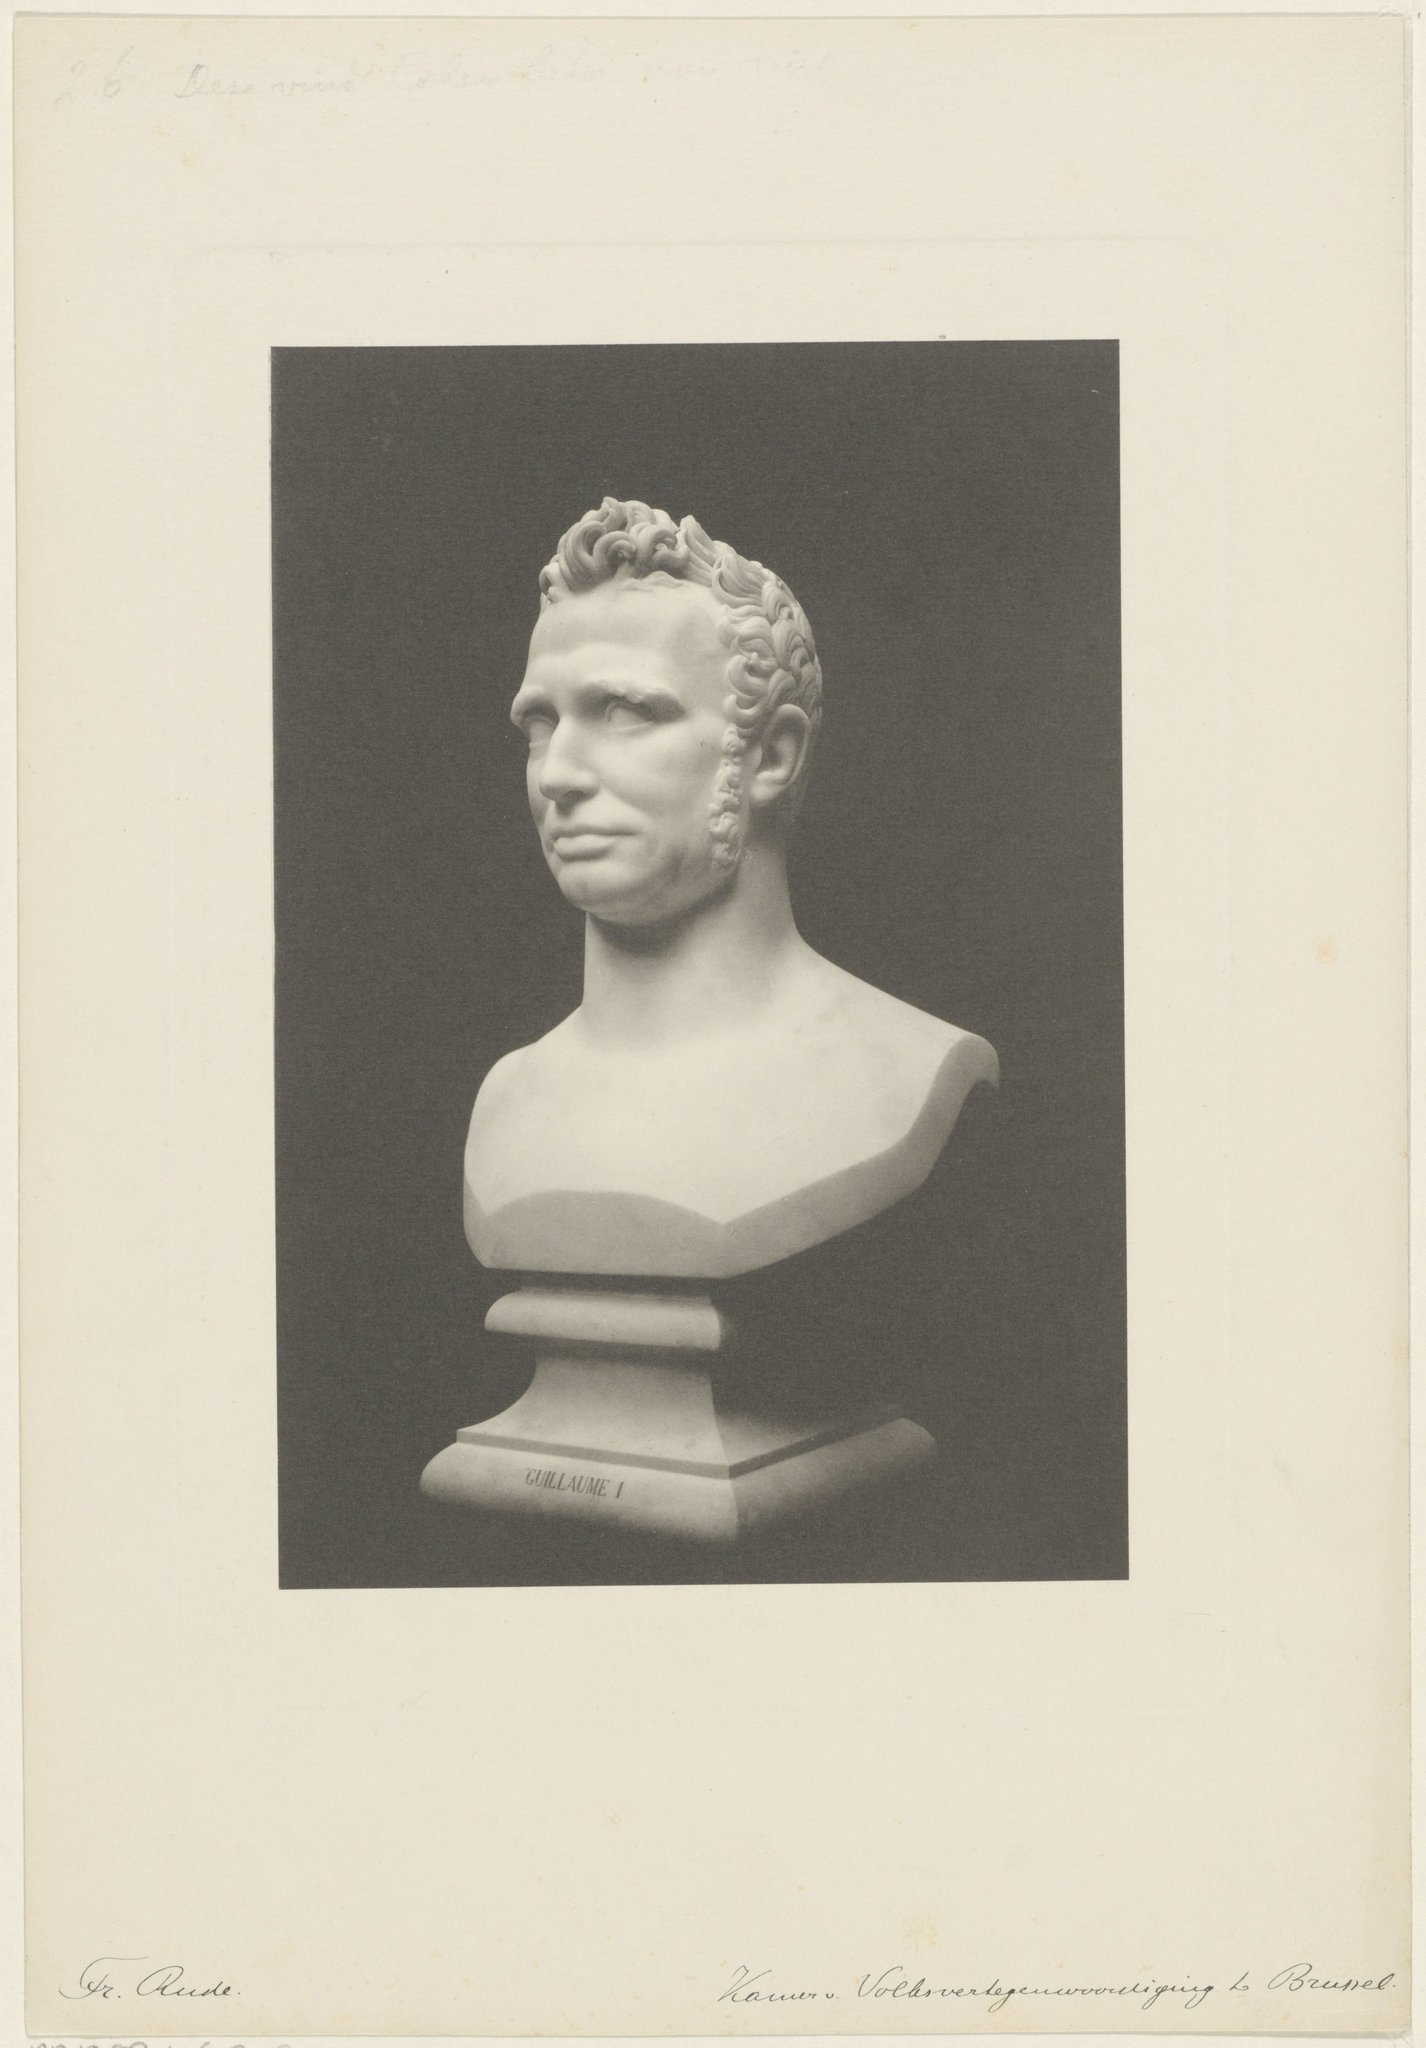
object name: photomechanical print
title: Buste van Willem I Frederik, koning der Nederlanden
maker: Anonymous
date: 1850-1949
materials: paper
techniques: photograph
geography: netherlands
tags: the hague, berlin, william i of the netherlands, piece of sculpture, reproduction of a piece of sculpture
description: De hier vermelde titel verwijst naar de hoogst verkregen titel van de geportretteerde, niet per se naar de titel die de geportretteerde op deze voorstelling draagt.